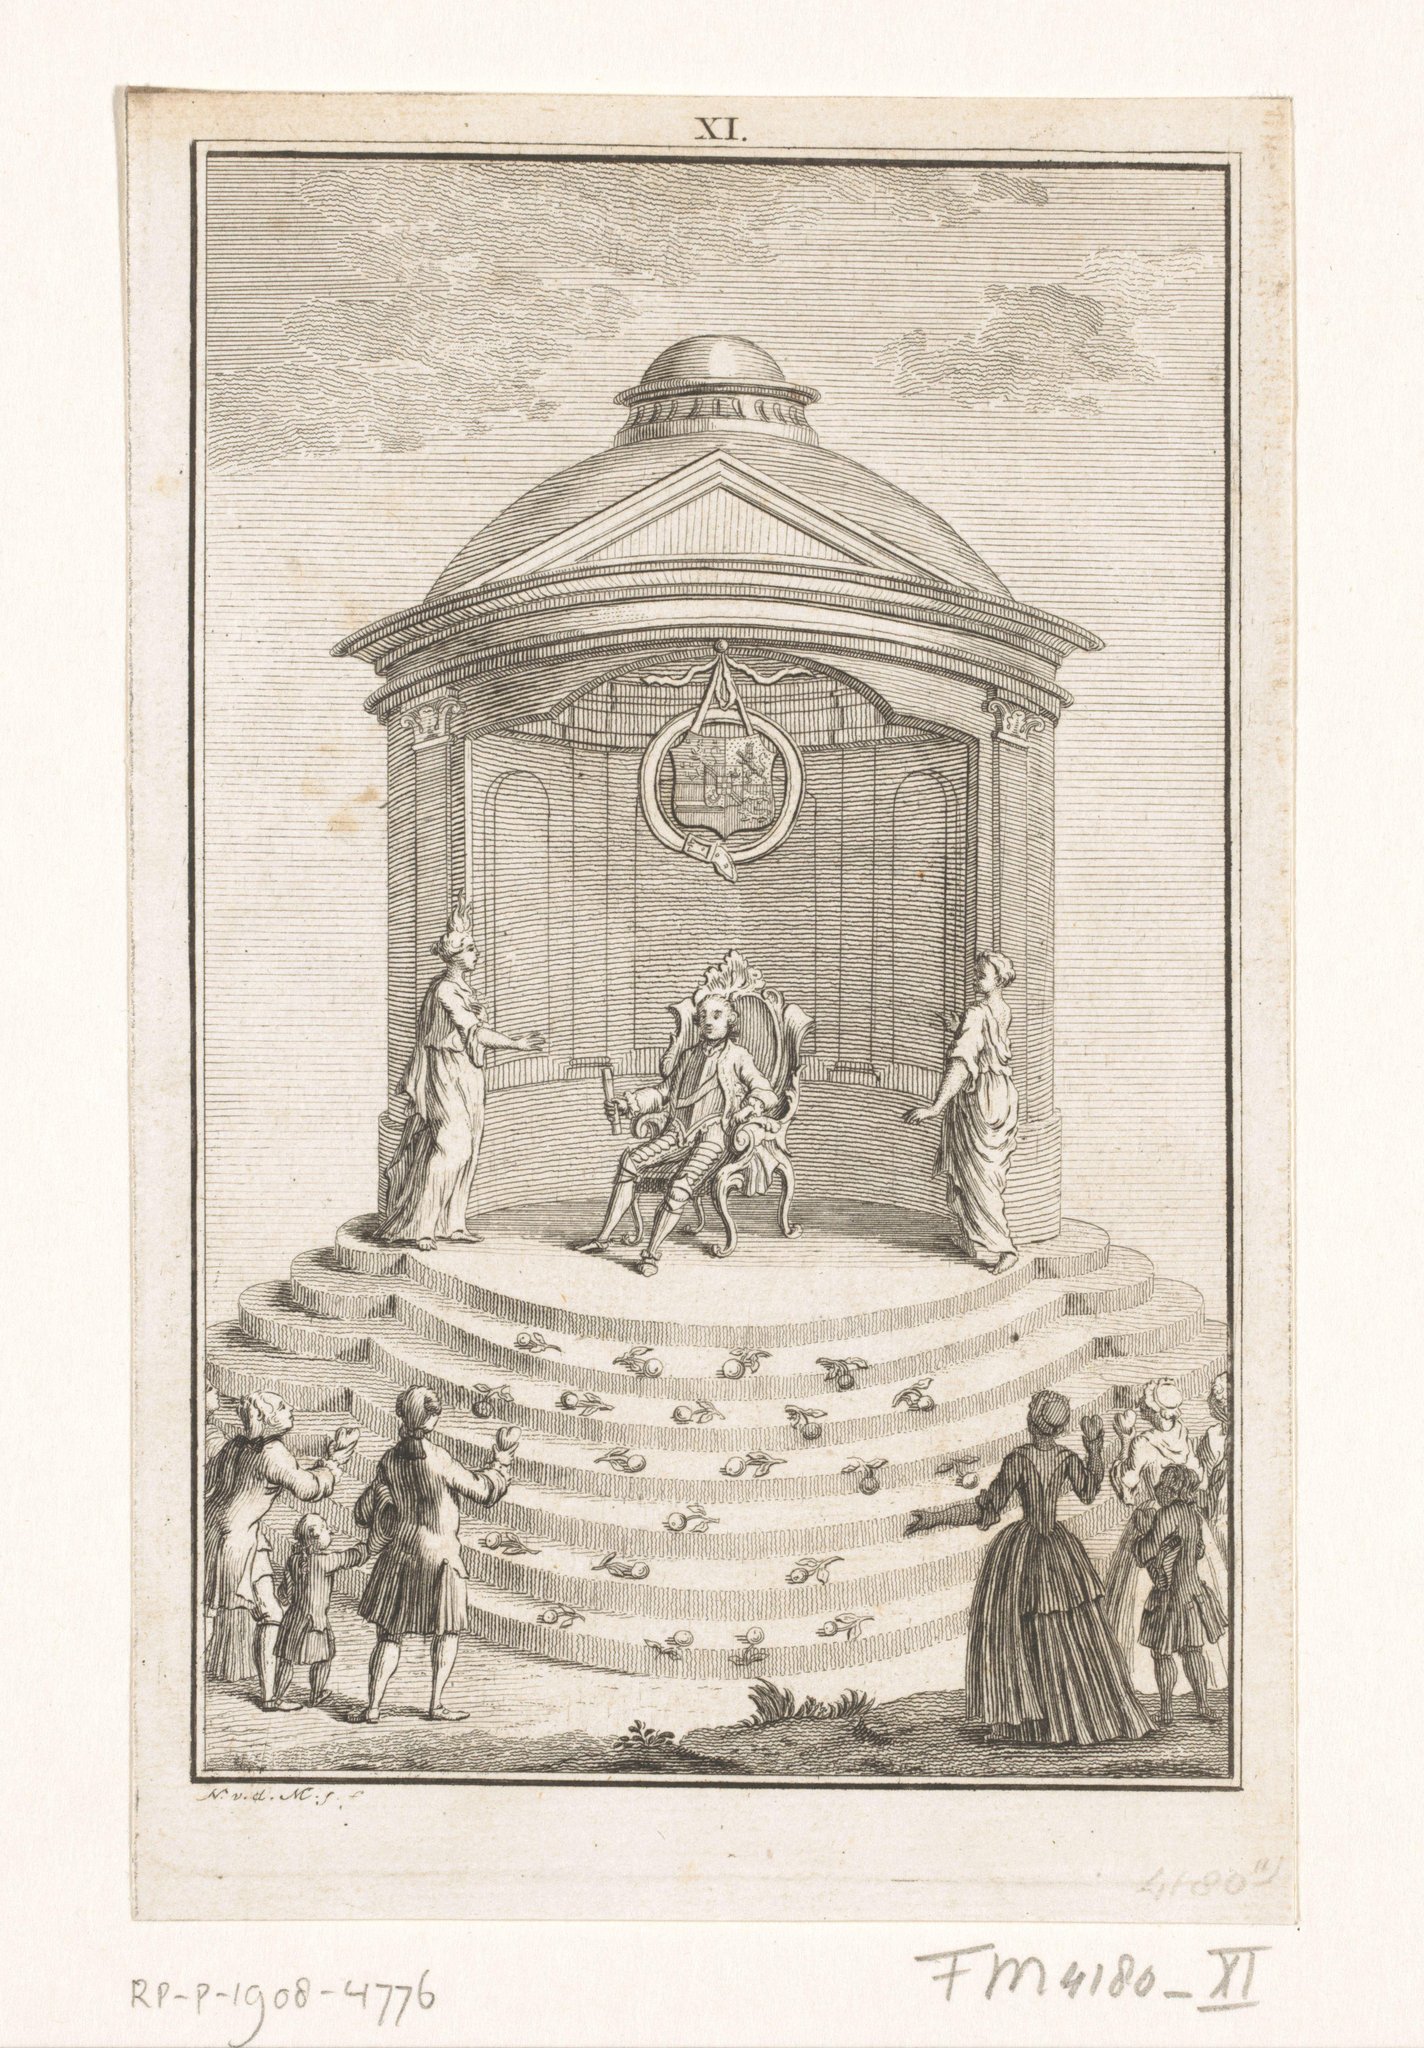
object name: print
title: Decoratie in het huis van kapitein P. Clockener te Amsterdam, 1766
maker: noach van der meer (ii)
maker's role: draughtsman, print maker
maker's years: 1741-1822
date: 1774-1776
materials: paper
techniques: engraving, etching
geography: northern netherlands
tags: the hague, william v (prince of orange), bonfire, fire-works (+ festive decoration ~ festive activities)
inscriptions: collector's mark: Lugt 2228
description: Decoratie aangebracht in het huis van kapitein Pieter Clockener aan de Warmoesstraat te Amsterdam. Voorstelling van de stadhouder zittend op een troon in de Tempel der Wijsheid. Ter gelegenheid van de meerderjarigheid van prins Willem V op 8 maart 1766. Genummerd bovenaan: XI.